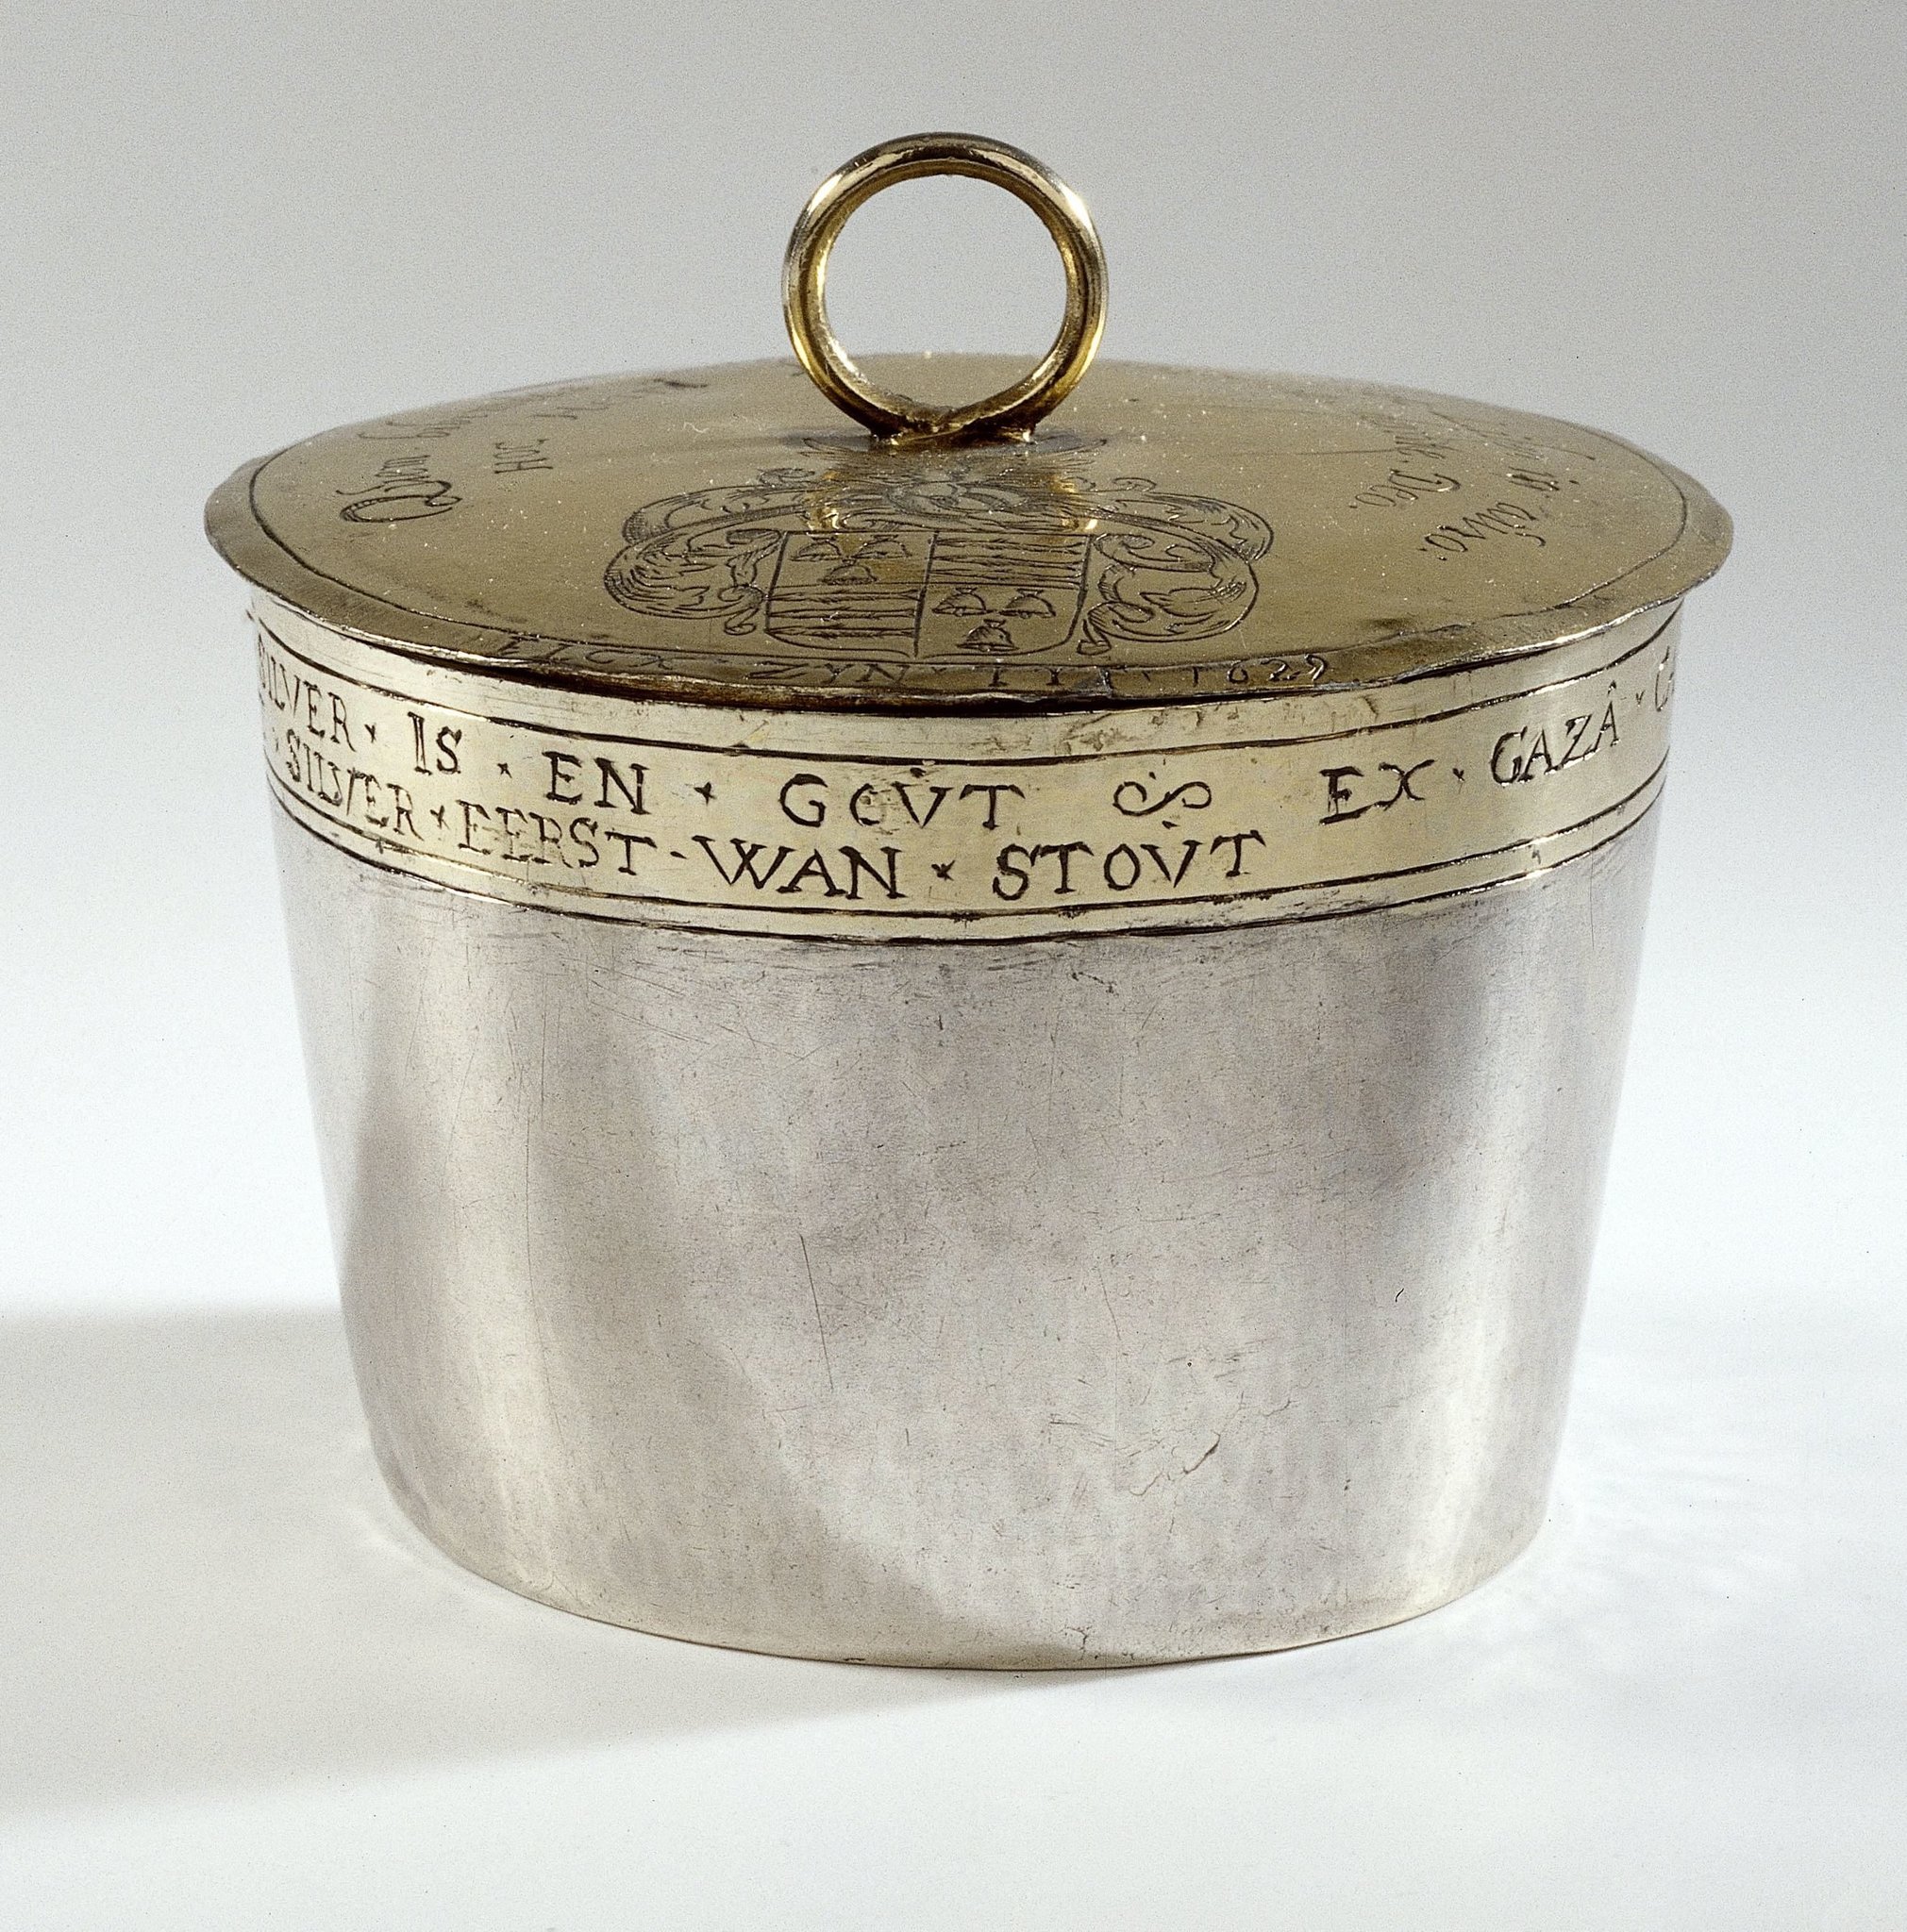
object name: kroes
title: Three Wine Cups Made with Booty from the Silver Fleet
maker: roelant gerobulus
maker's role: goldsmith, silversmith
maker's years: -1632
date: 1629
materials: silver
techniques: engraving, forging, gilding, striking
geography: utrecht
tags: delfshaven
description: This set of matching, nesting wine cups was made to honour Piet Heinâ€™s victory over the Spanish Treasure (or Silver) Fleet in 1628. This remarkable event is commemorated in the engraved text, which describes how the drinking vessels were fashioned from confiscated precious metal. The coat-of-arms of the commissioner, probably a member of the Sweers family, is engraved on the bottoms and lids.